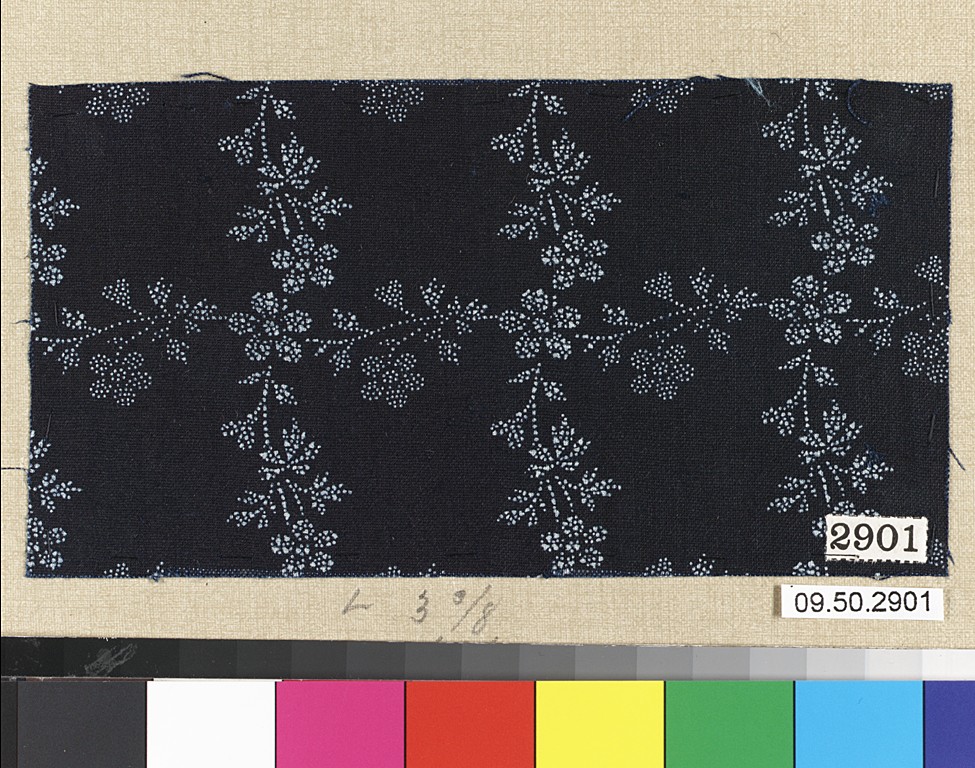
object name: piece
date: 1801-1900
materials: cotton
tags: flowers,leaves